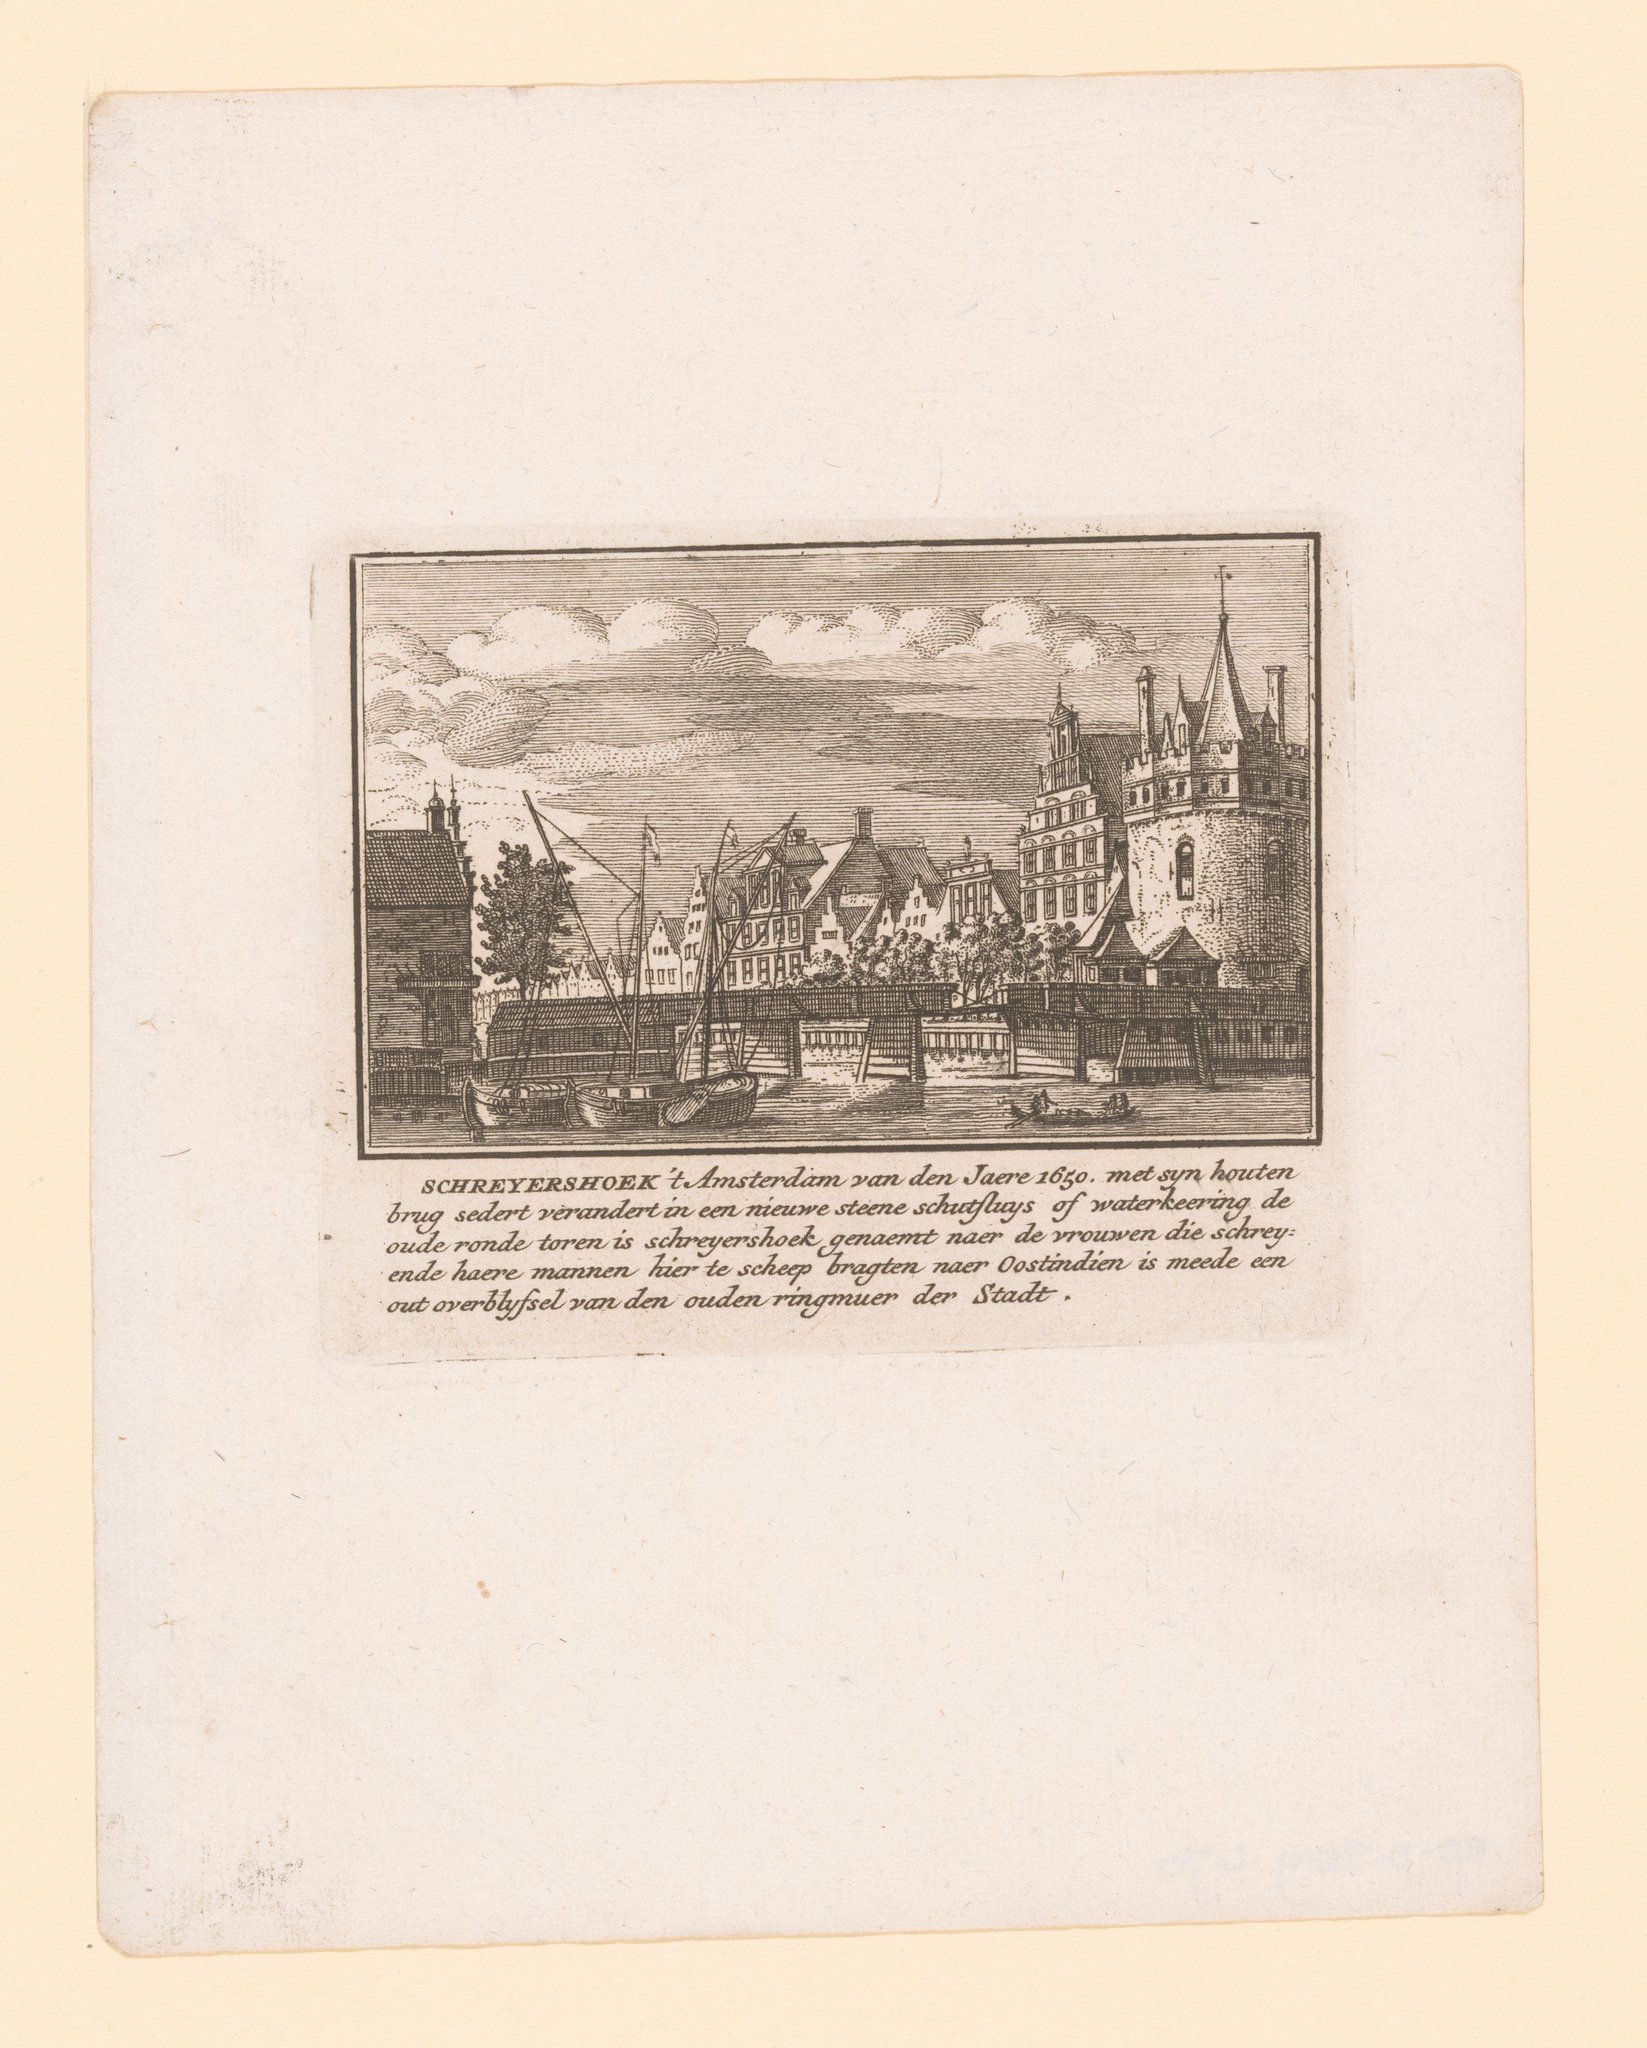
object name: print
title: Schreyershoek 't Amsterdam van den jaere 1650 (...)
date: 1726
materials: paper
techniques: engraving, etching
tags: urban housing, sailing-ship, sailing-boat, towers ~ fortified city, rowing-boat, canoe, etc., bridge in city across river, canal, etc.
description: Prent uit: Rademaker, Abraham. Versameling van 100. Nederlantse Outheden en Gesigten / Versameling van 100 Nederlantsche outheden en gesigten. Amsterdam: Isaac Greve, [ca. 1726].